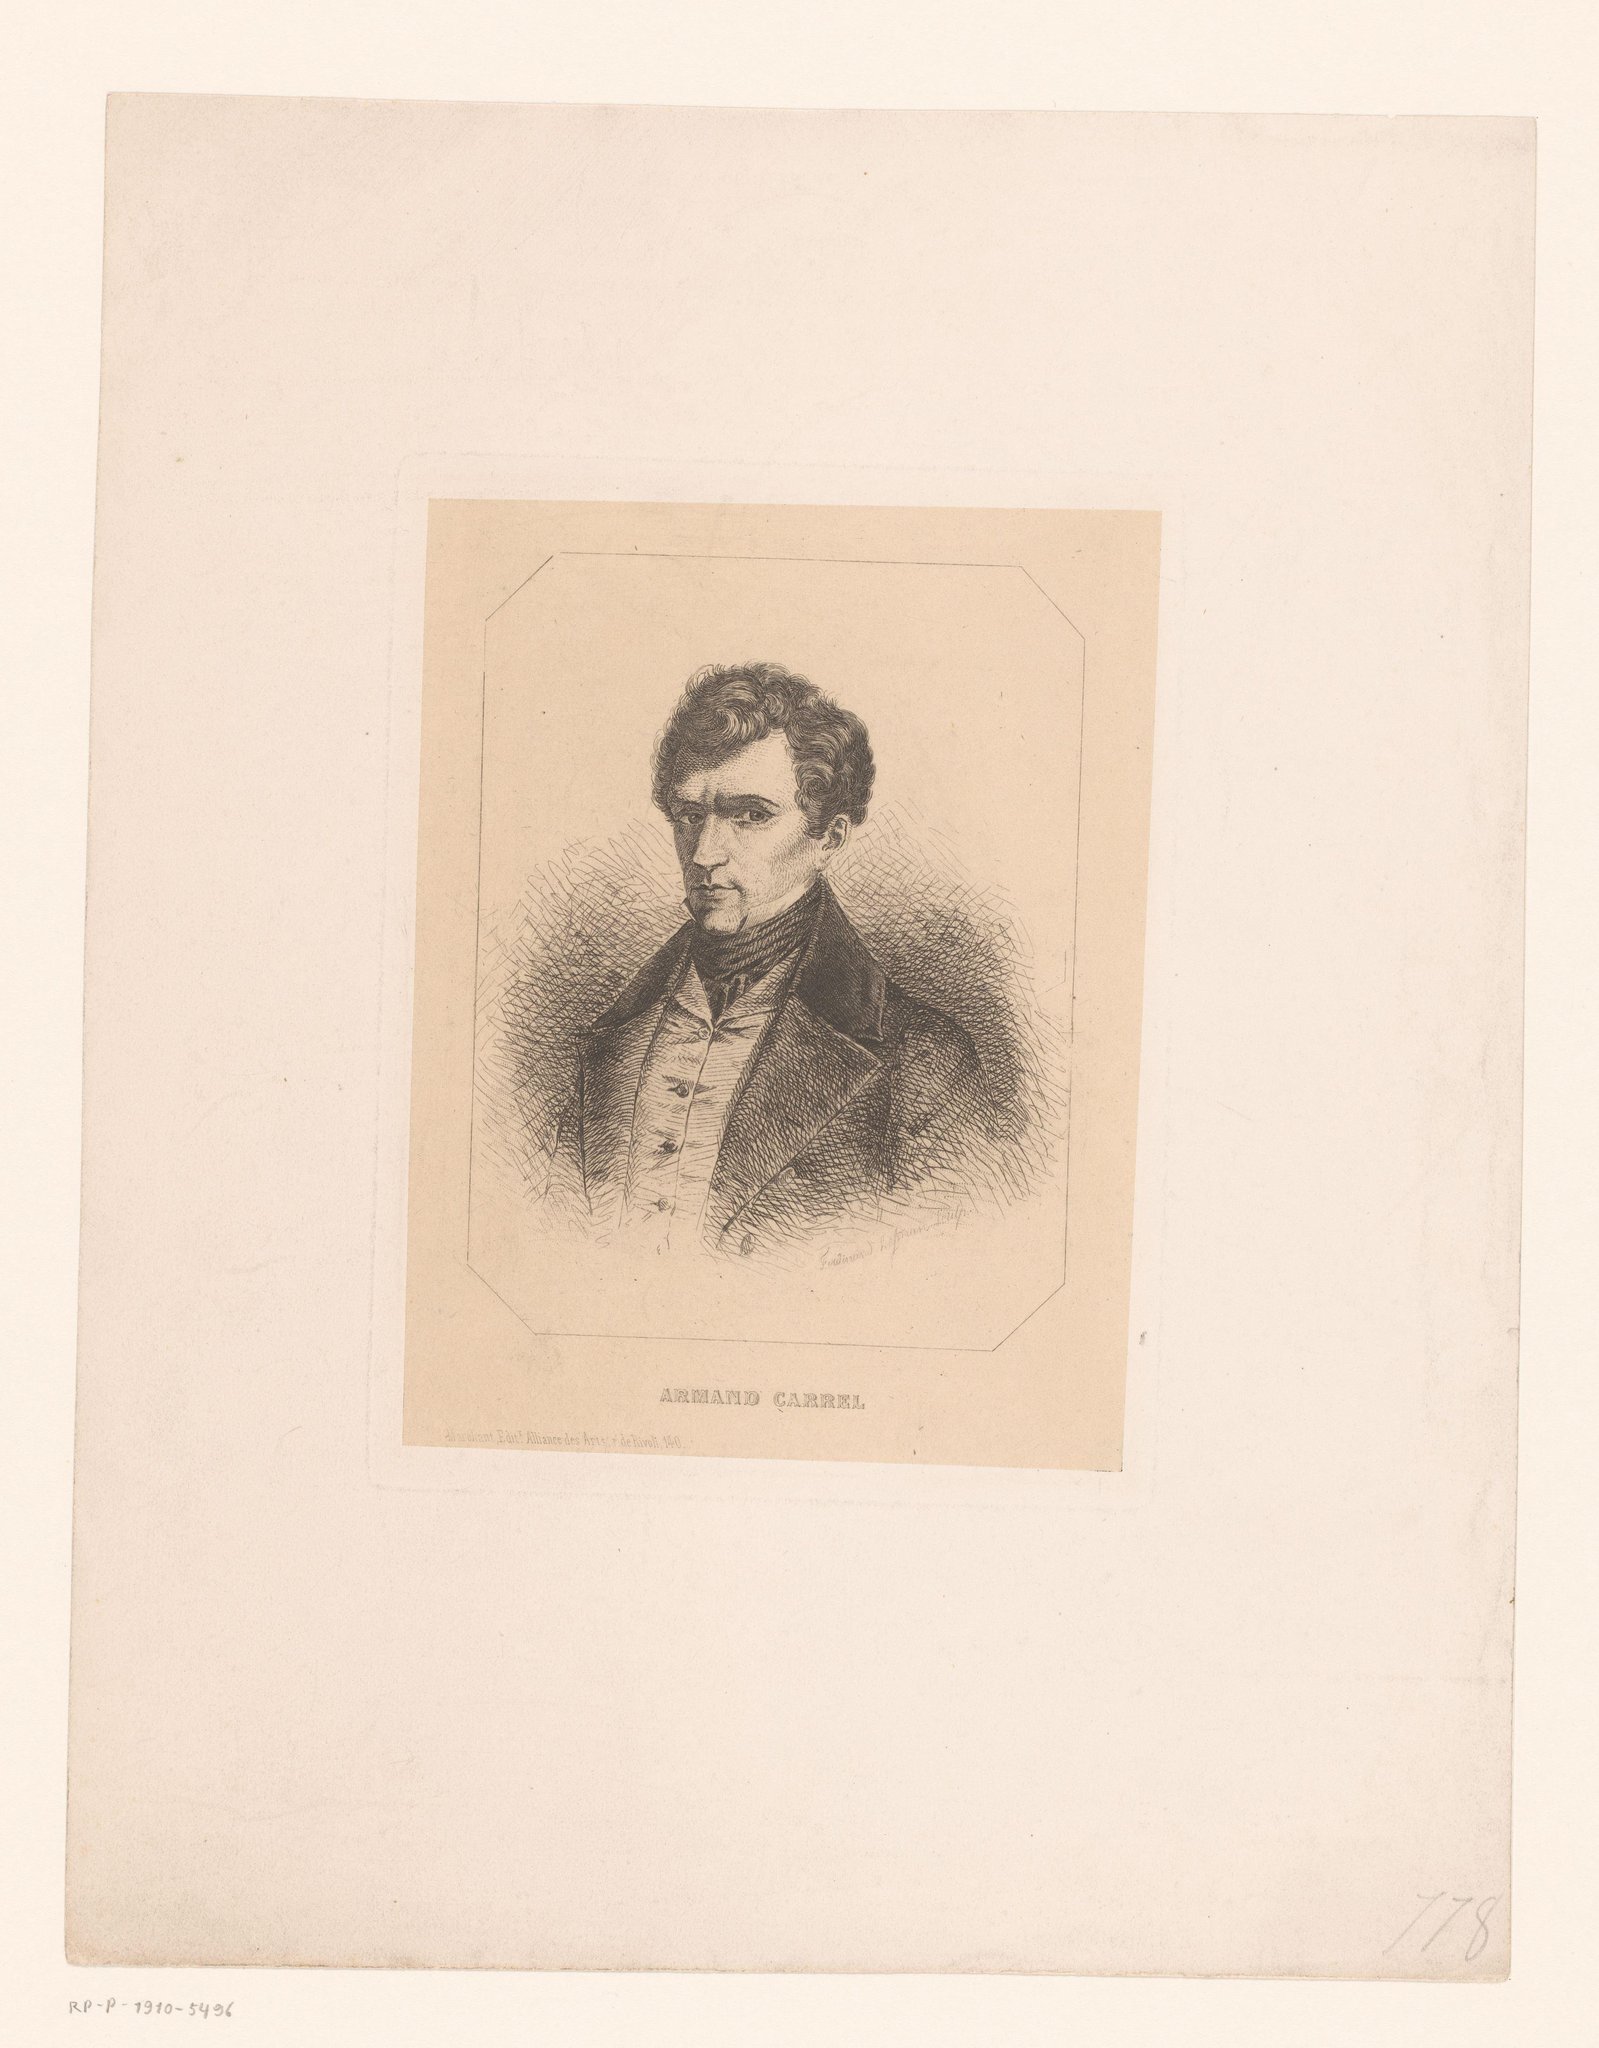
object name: print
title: Portret van Armand Carrel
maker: ferdinand lehman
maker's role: print maker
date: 1820-1900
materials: paper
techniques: engraving, etching, roulette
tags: historical persons, portrait of a writer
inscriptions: collector's mark: Lugt 2228